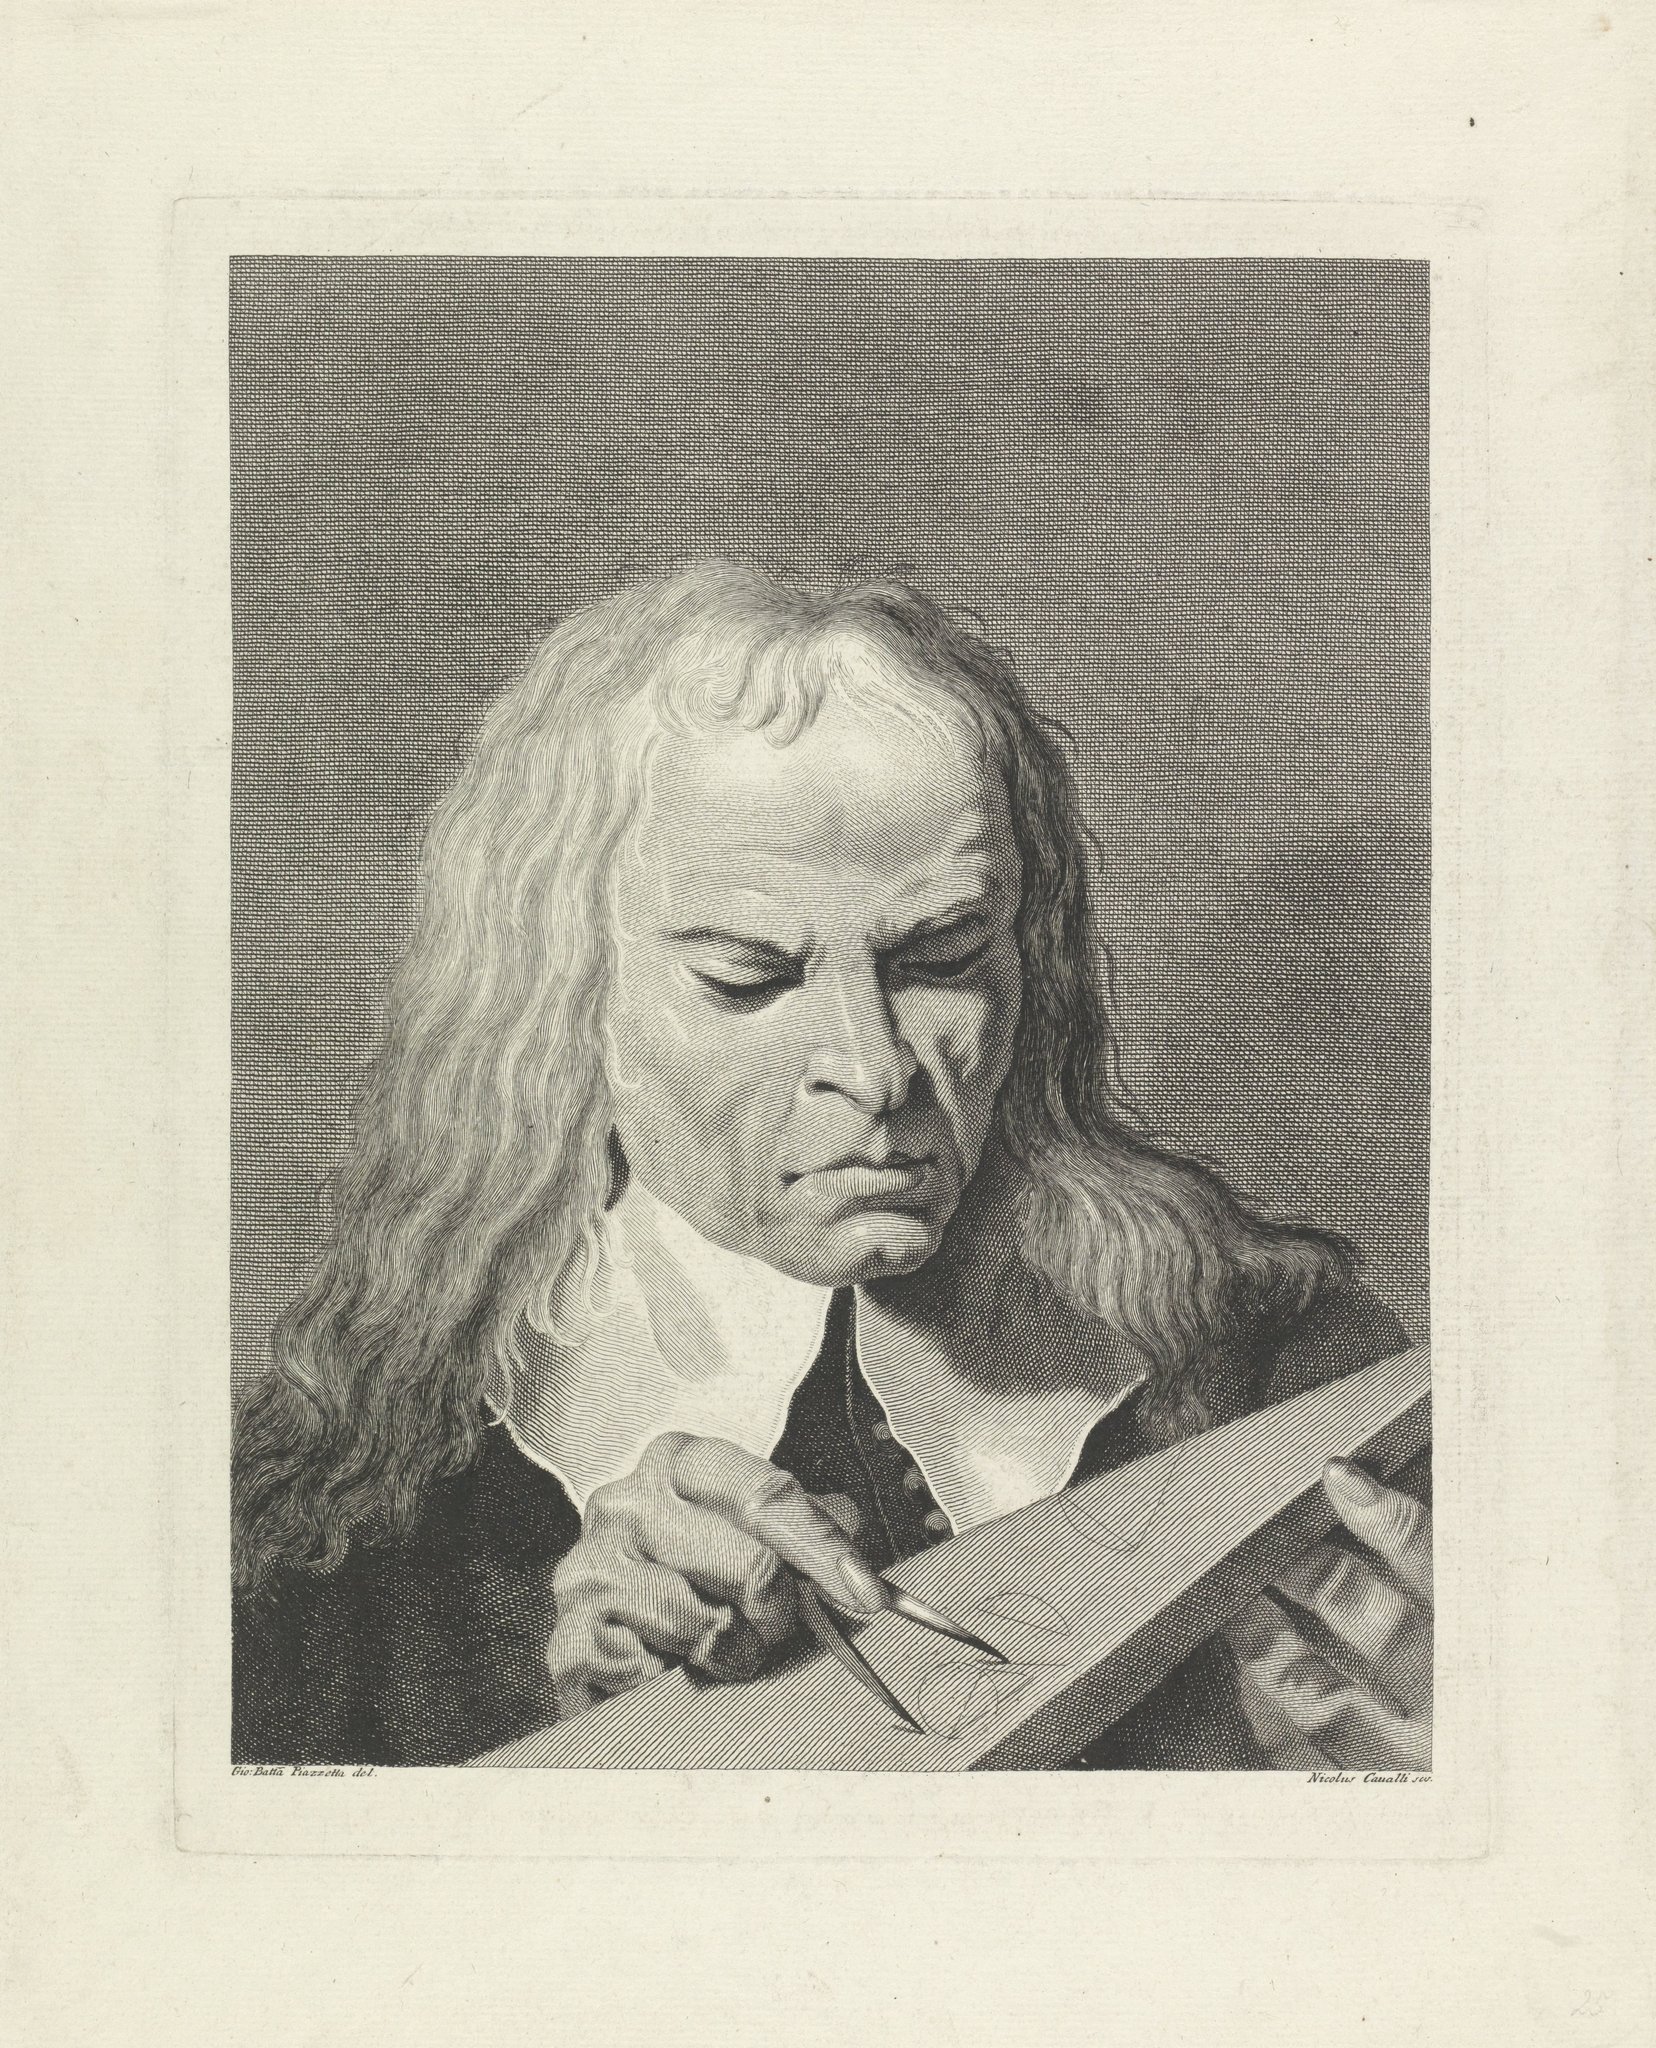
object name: print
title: Mathematicus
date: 1740-1822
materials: paper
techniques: engraving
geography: italy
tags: drawing (mathematics), compasses, mathematics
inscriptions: collector's mark: Lugt 240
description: Een mathematicus die geconcentreerd met een passer een figuur opmeet op het vel papier dat hij in zijn handen heeft.